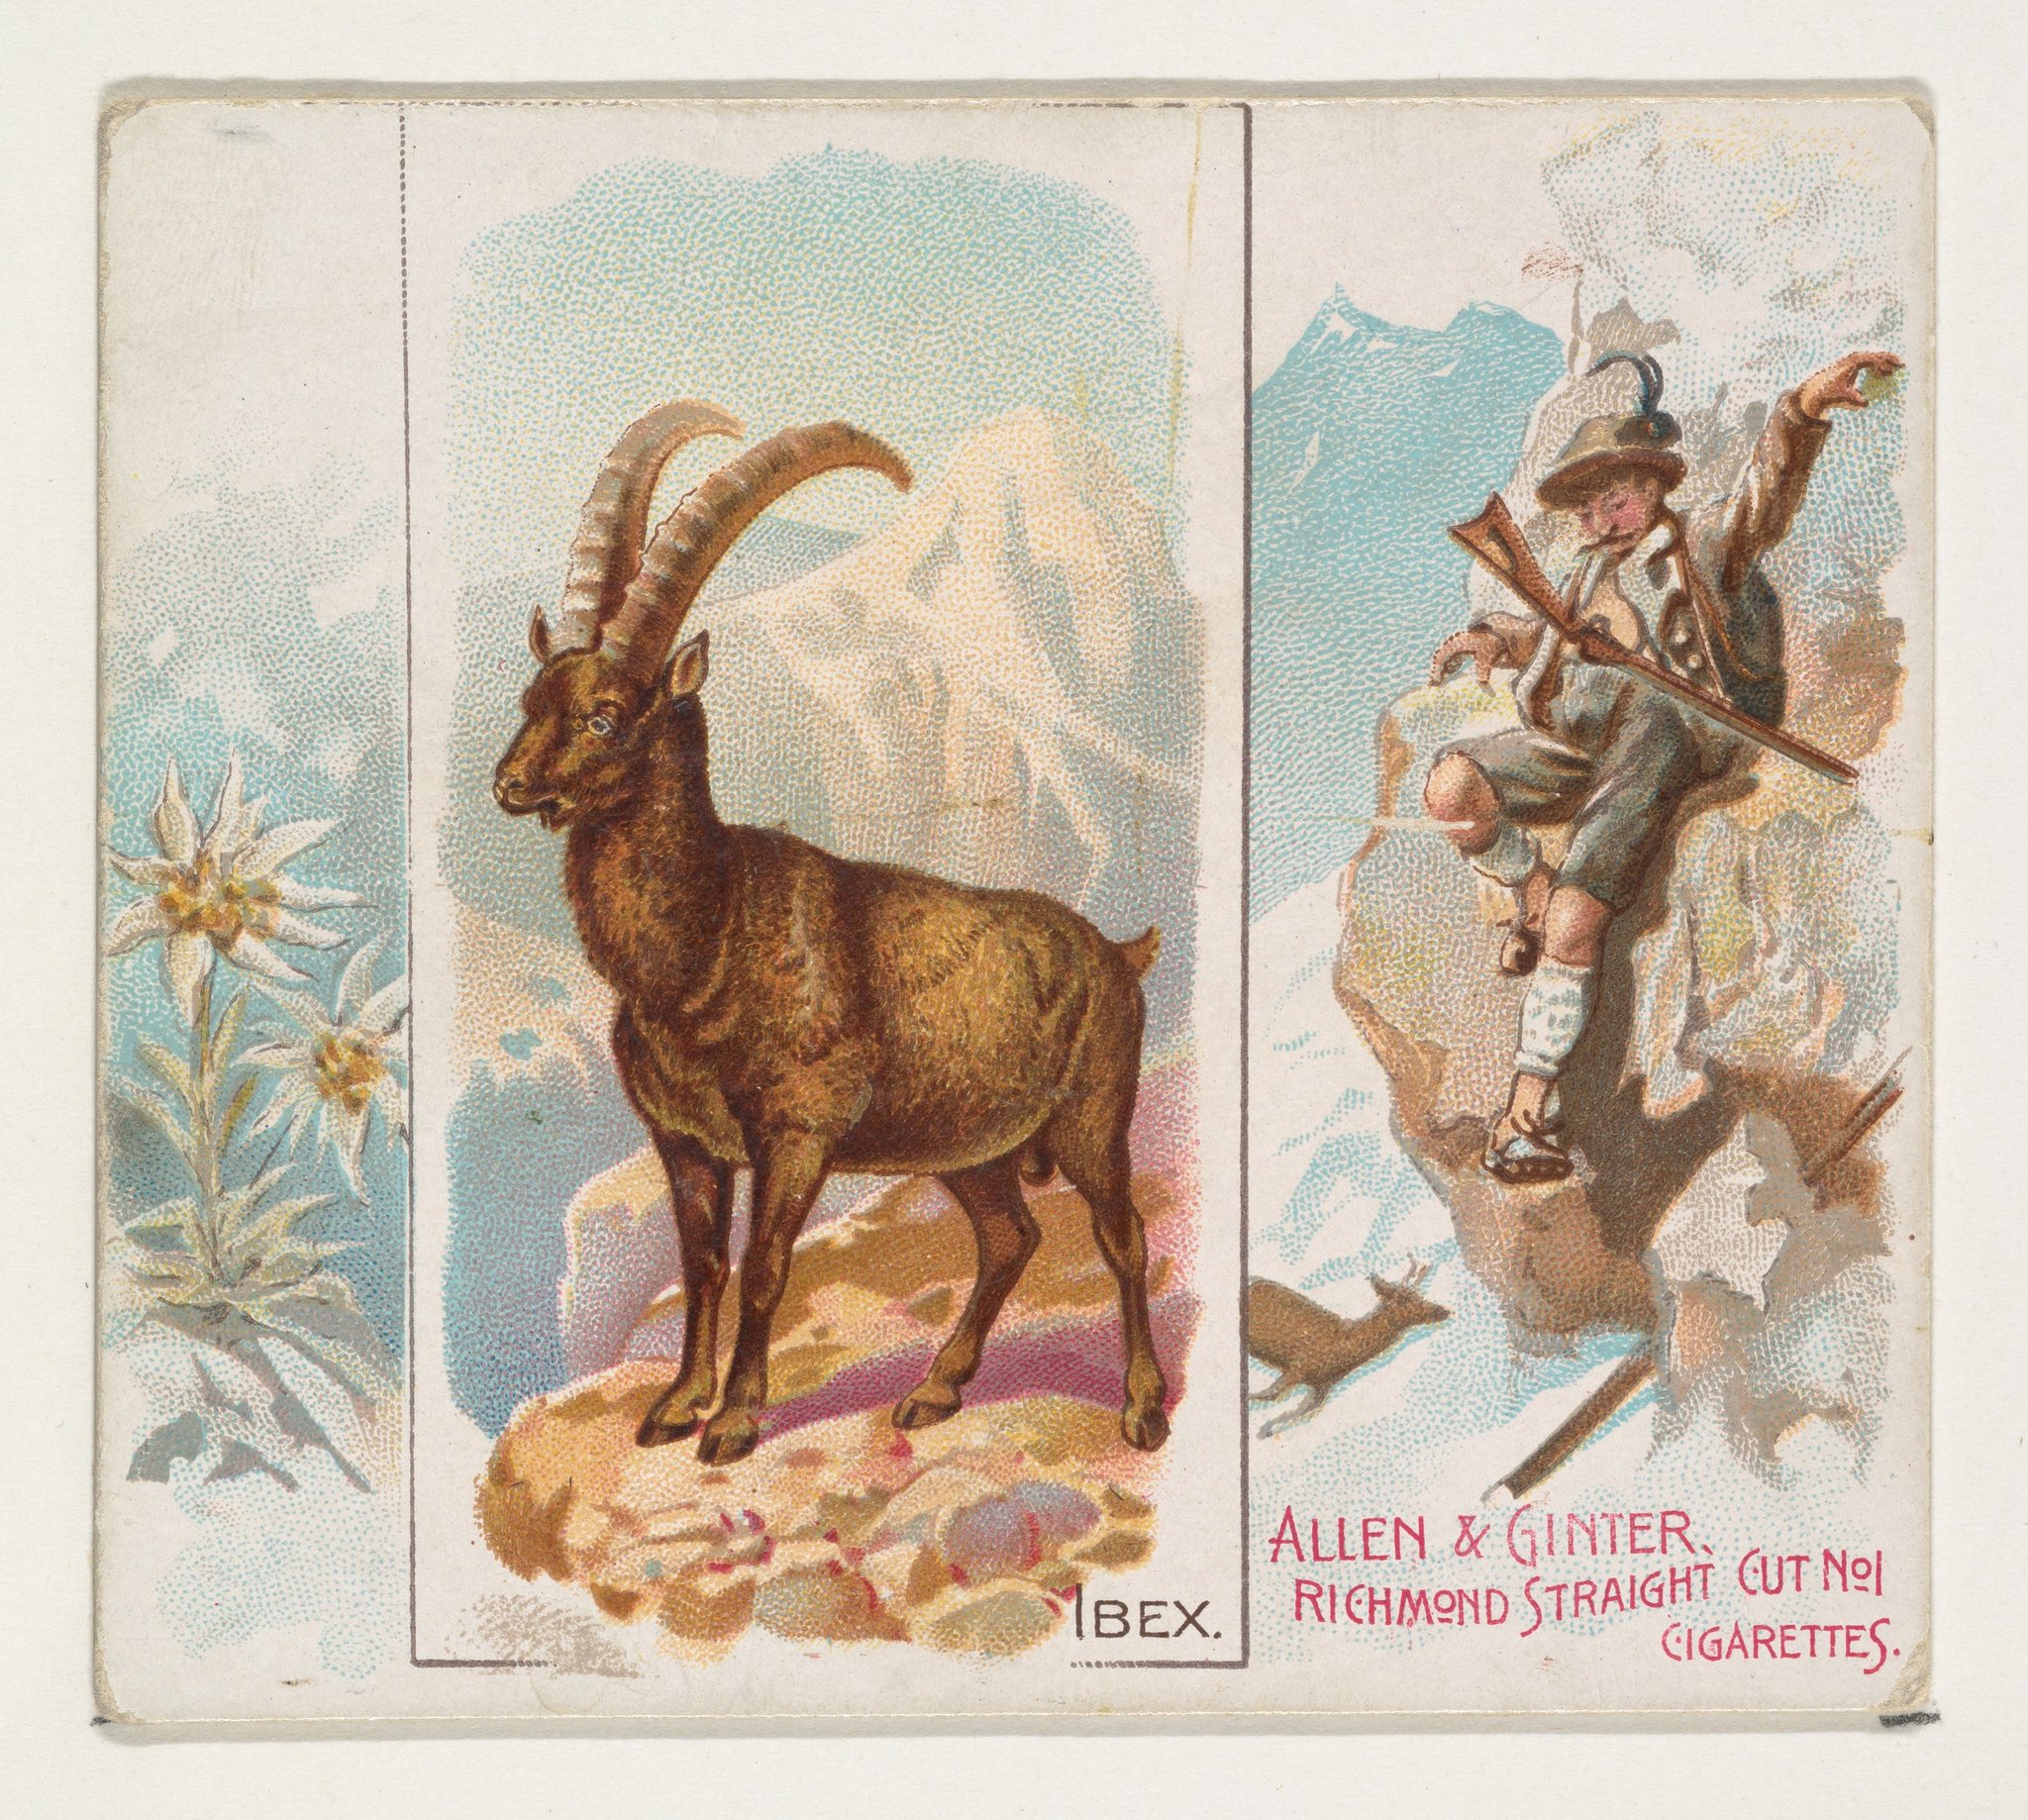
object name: print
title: Ibex, from Quadrupeds series (N41) for Allen & Ginter Cigarettes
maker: allen & ginter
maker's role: publisher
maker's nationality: american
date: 1890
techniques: color lithograph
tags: men,ibex